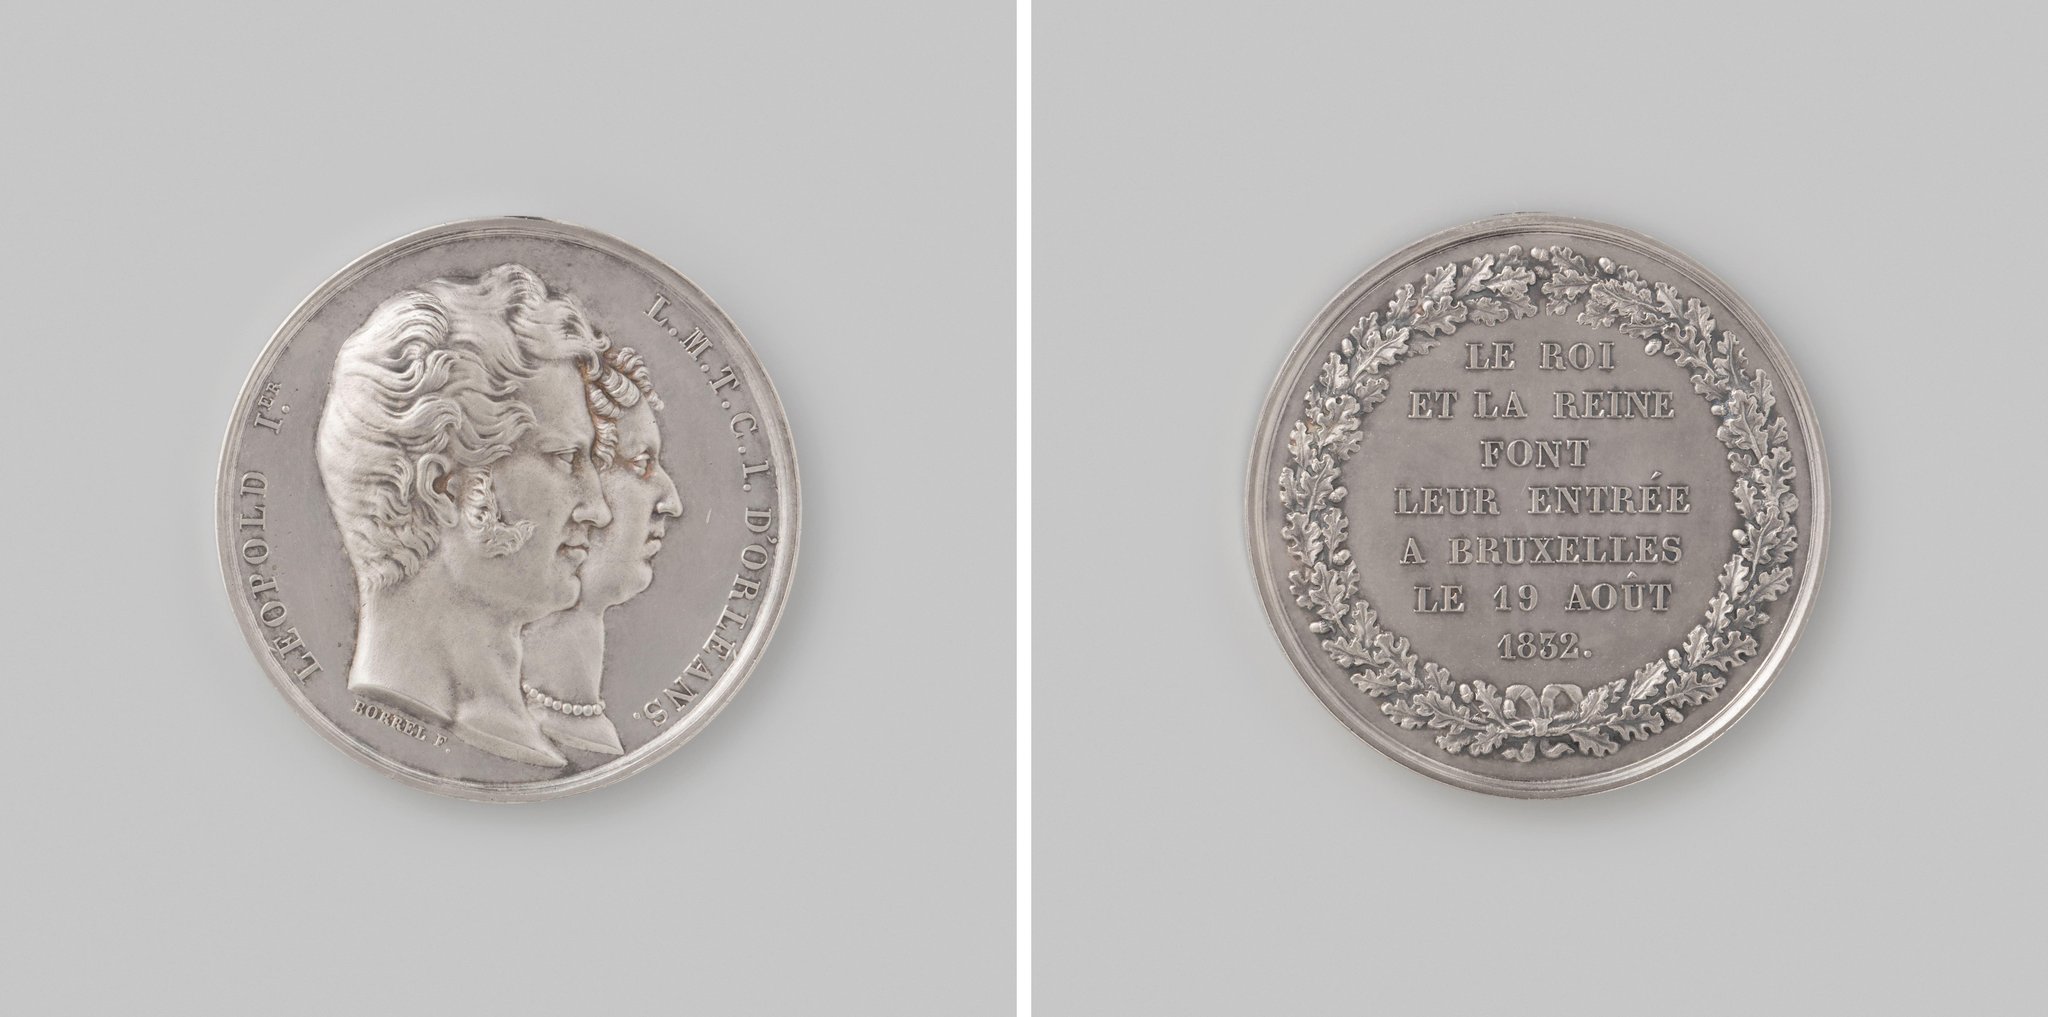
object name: history medal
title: Intocht van Leopold I en Louise Maria, koning en koningin der Belgen te Brussel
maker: m. borrel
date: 1832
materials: silver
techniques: striking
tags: louise marie van orléans (koningin van belgië), laeken, leopold i (koning der belgen), brussels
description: Zilveren penning. Voorzijde: borststuk man en vrouw binnen omschrift. Keerzijde: opschrift binnen eikekrans